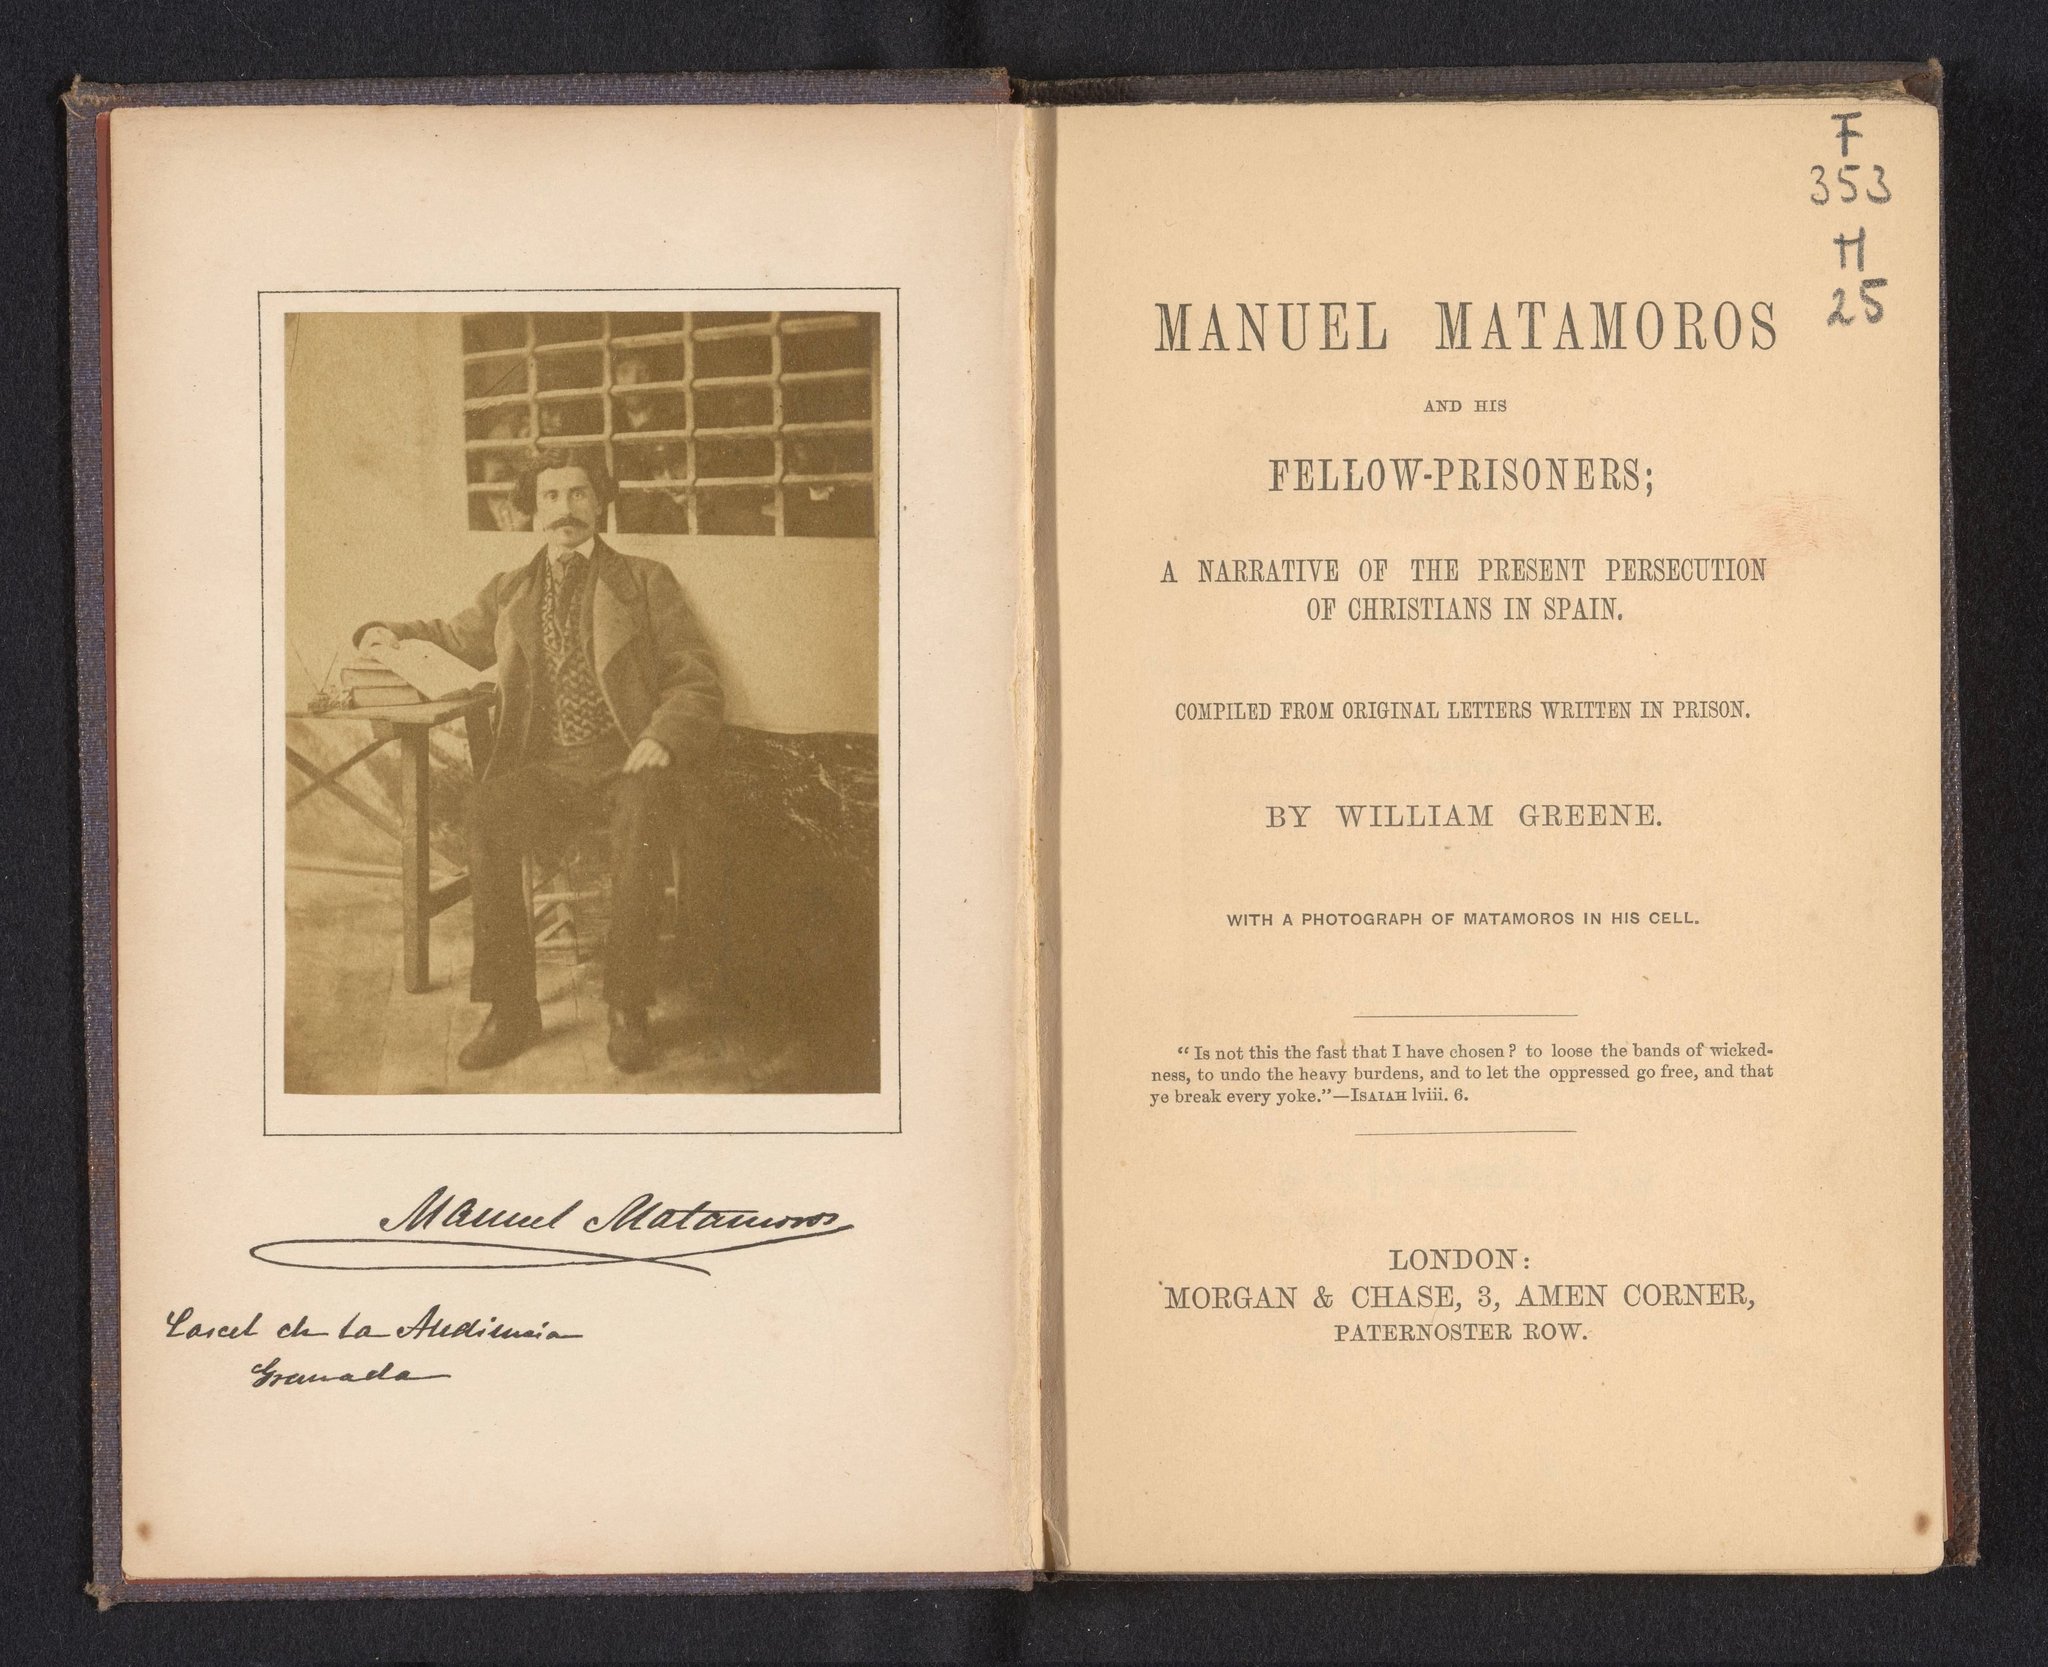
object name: photograph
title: Portret van Manuel Matamoros in zijn cel te Granada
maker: Anonymous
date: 1858-1863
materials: photographic support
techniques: albumen print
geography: granada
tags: clergyman, prison, jail, prisoner; in fetters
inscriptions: inscription: ‘Manuel Matamoros Larcel de la Audienzia Granada’